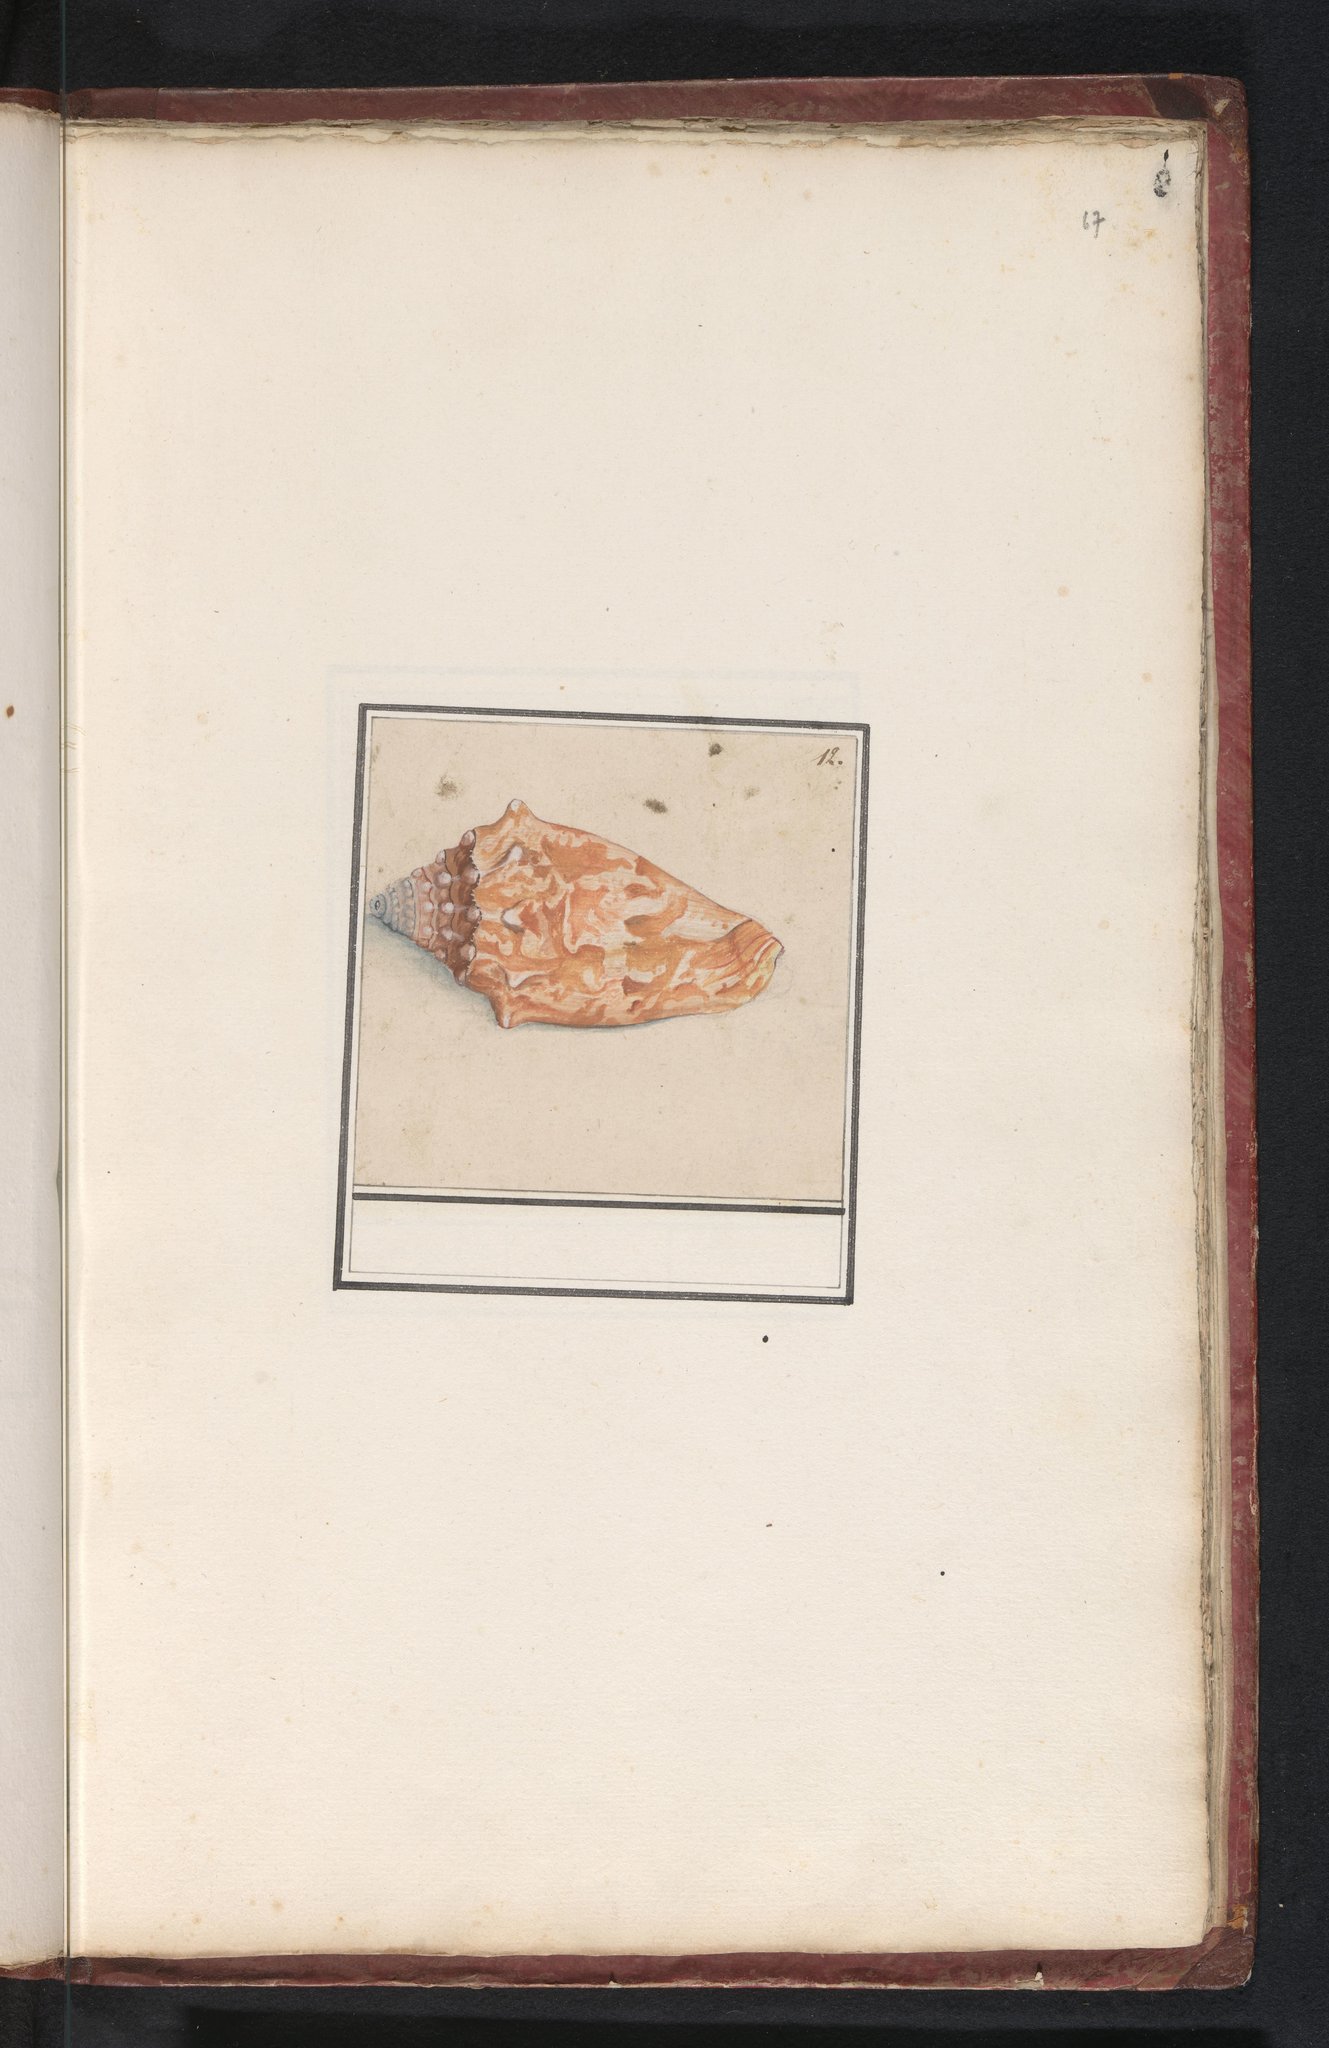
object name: drawing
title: Roze vleugelhoorn (Strombus gigas)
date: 1596-1610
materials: chalk, paint, paper, pencil, watercolor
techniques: brush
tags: molluscs: queen conch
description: Roze vleugelhoorn. Genummerd rechtsboven: 12. Onderdeel van het zesde album met tekeningen van vissen, schelpen en insekten. Zesde van twaalf albums met tekeningen van dieren, vogels en planten bekend rond 1600, gemaakt in opdracht van keizer Rudolf II. Met toelichting in Nederlands, Latijn en Frans.